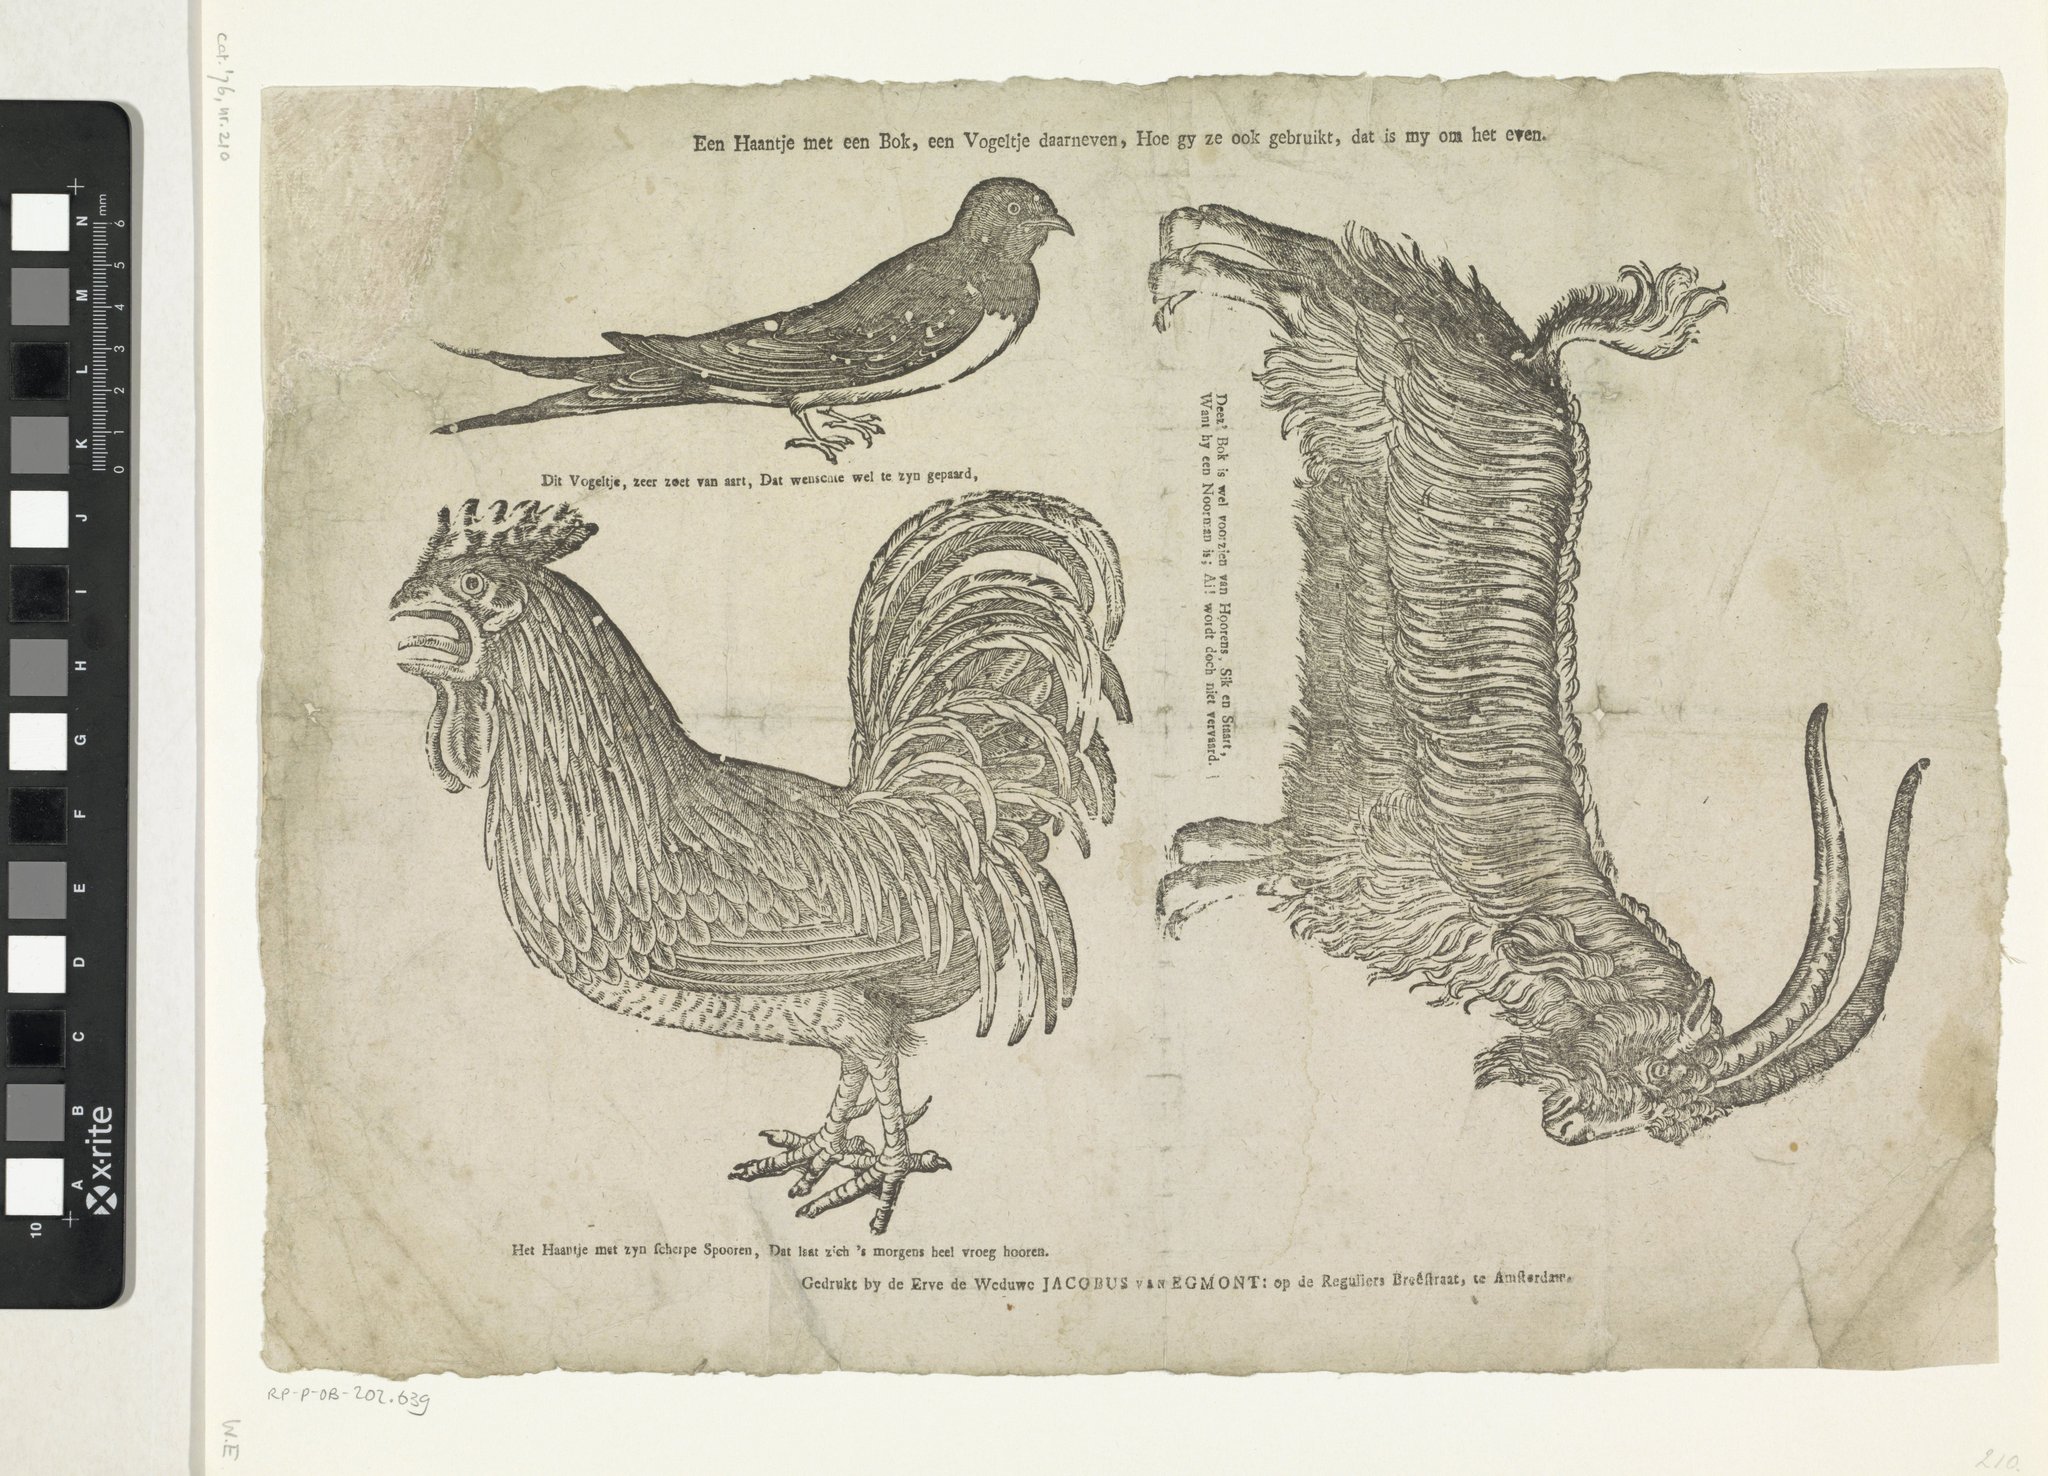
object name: print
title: Een haantje met een bok, een vogeltje daarneven, Hoe gy ze ook gebruikt, dat is my on het even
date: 1551-1555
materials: paper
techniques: letterpress printing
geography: amsterdam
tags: animals, birds, he-goat, billy-goat, fowl (cock, hen, chicken, etc.)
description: Voor het drukken van deze prent is gebruik gemaakt van bestaande houtblokken die in de zestiende eeuw gebruikt werden voor de befaamde natuurhistorische boeken van de Zwitser Conrad Gessner. Minstens een deel van de houtblokken voor de illustraties van Gessners werk bevond zich in de achttiende en vroege negentiende eeuw in Nederland. Daar werden ze benut voor het drukken van cents- of volksprenten. Opvallend is dat de dieren in de tekstjes die onder de afbeeldingen werden toegevoegd vaak anders zijn geduid dan bij Gessner. De bok komt voor in verschillende publicaties van Gessner, alsmede herdrukken daarvan, zoals het eerste deel van Historiae animalium (eerste uitgave 1551), Icones animalium quadrupedum (eerste uitgave 1553) en Thierbuch (eerste uitgave 1563). De vogel en haan komen voor in het derde deel van Gessners Historiae animalium (eerste uitgave 1555), zijn Icones avium (eerste uitgave 1555) en Vogelbuch (eerste uitgave 1557).